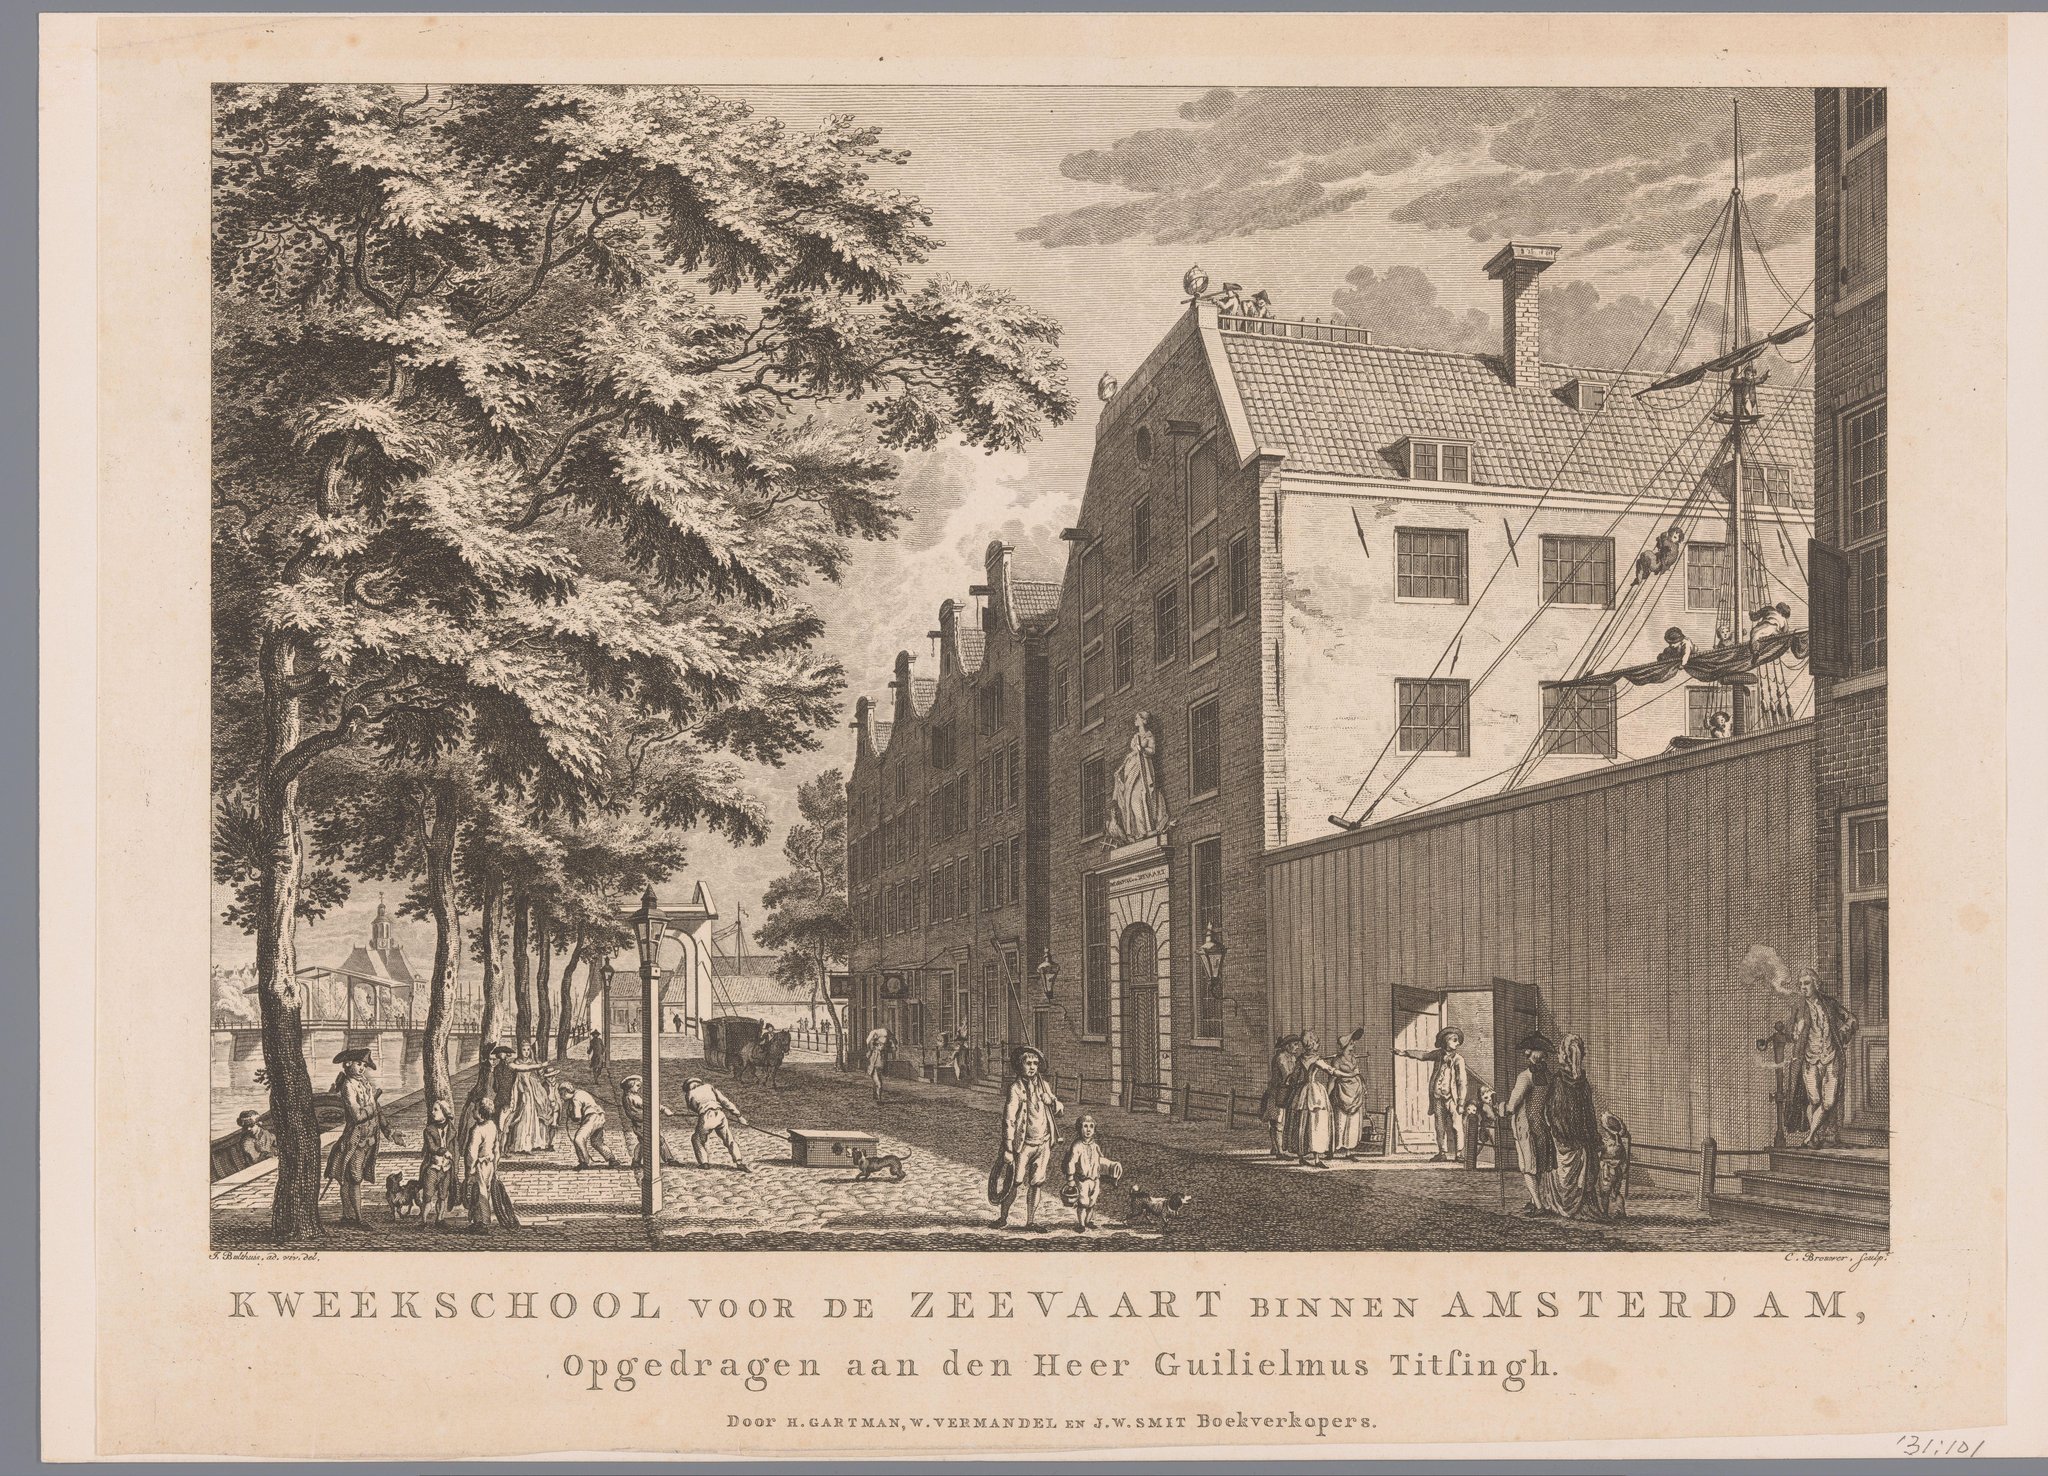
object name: print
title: Gezicht op de Kweekschool voor de Zeevaart te Amsterdam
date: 1784-1803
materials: paper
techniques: etching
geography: netherlands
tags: city-view in general; 'veduta'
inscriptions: collector's mark: Lugt 2233